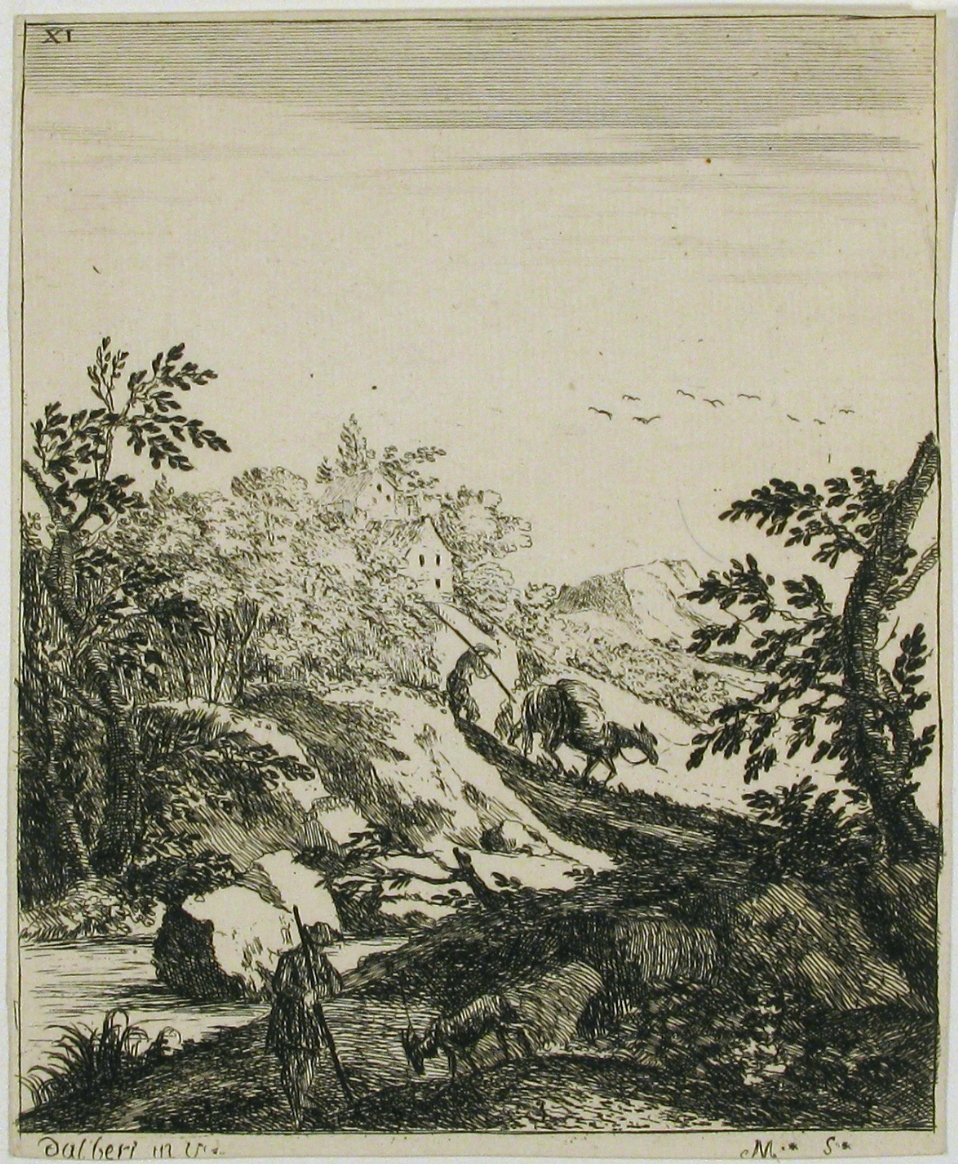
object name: print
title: Landscape with a Goatherd and a Drover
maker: charles françois césar le tellier, marquis montmirail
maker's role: artist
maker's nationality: french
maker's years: 1734-1764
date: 1734-1766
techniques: etching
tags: men,goats,trees